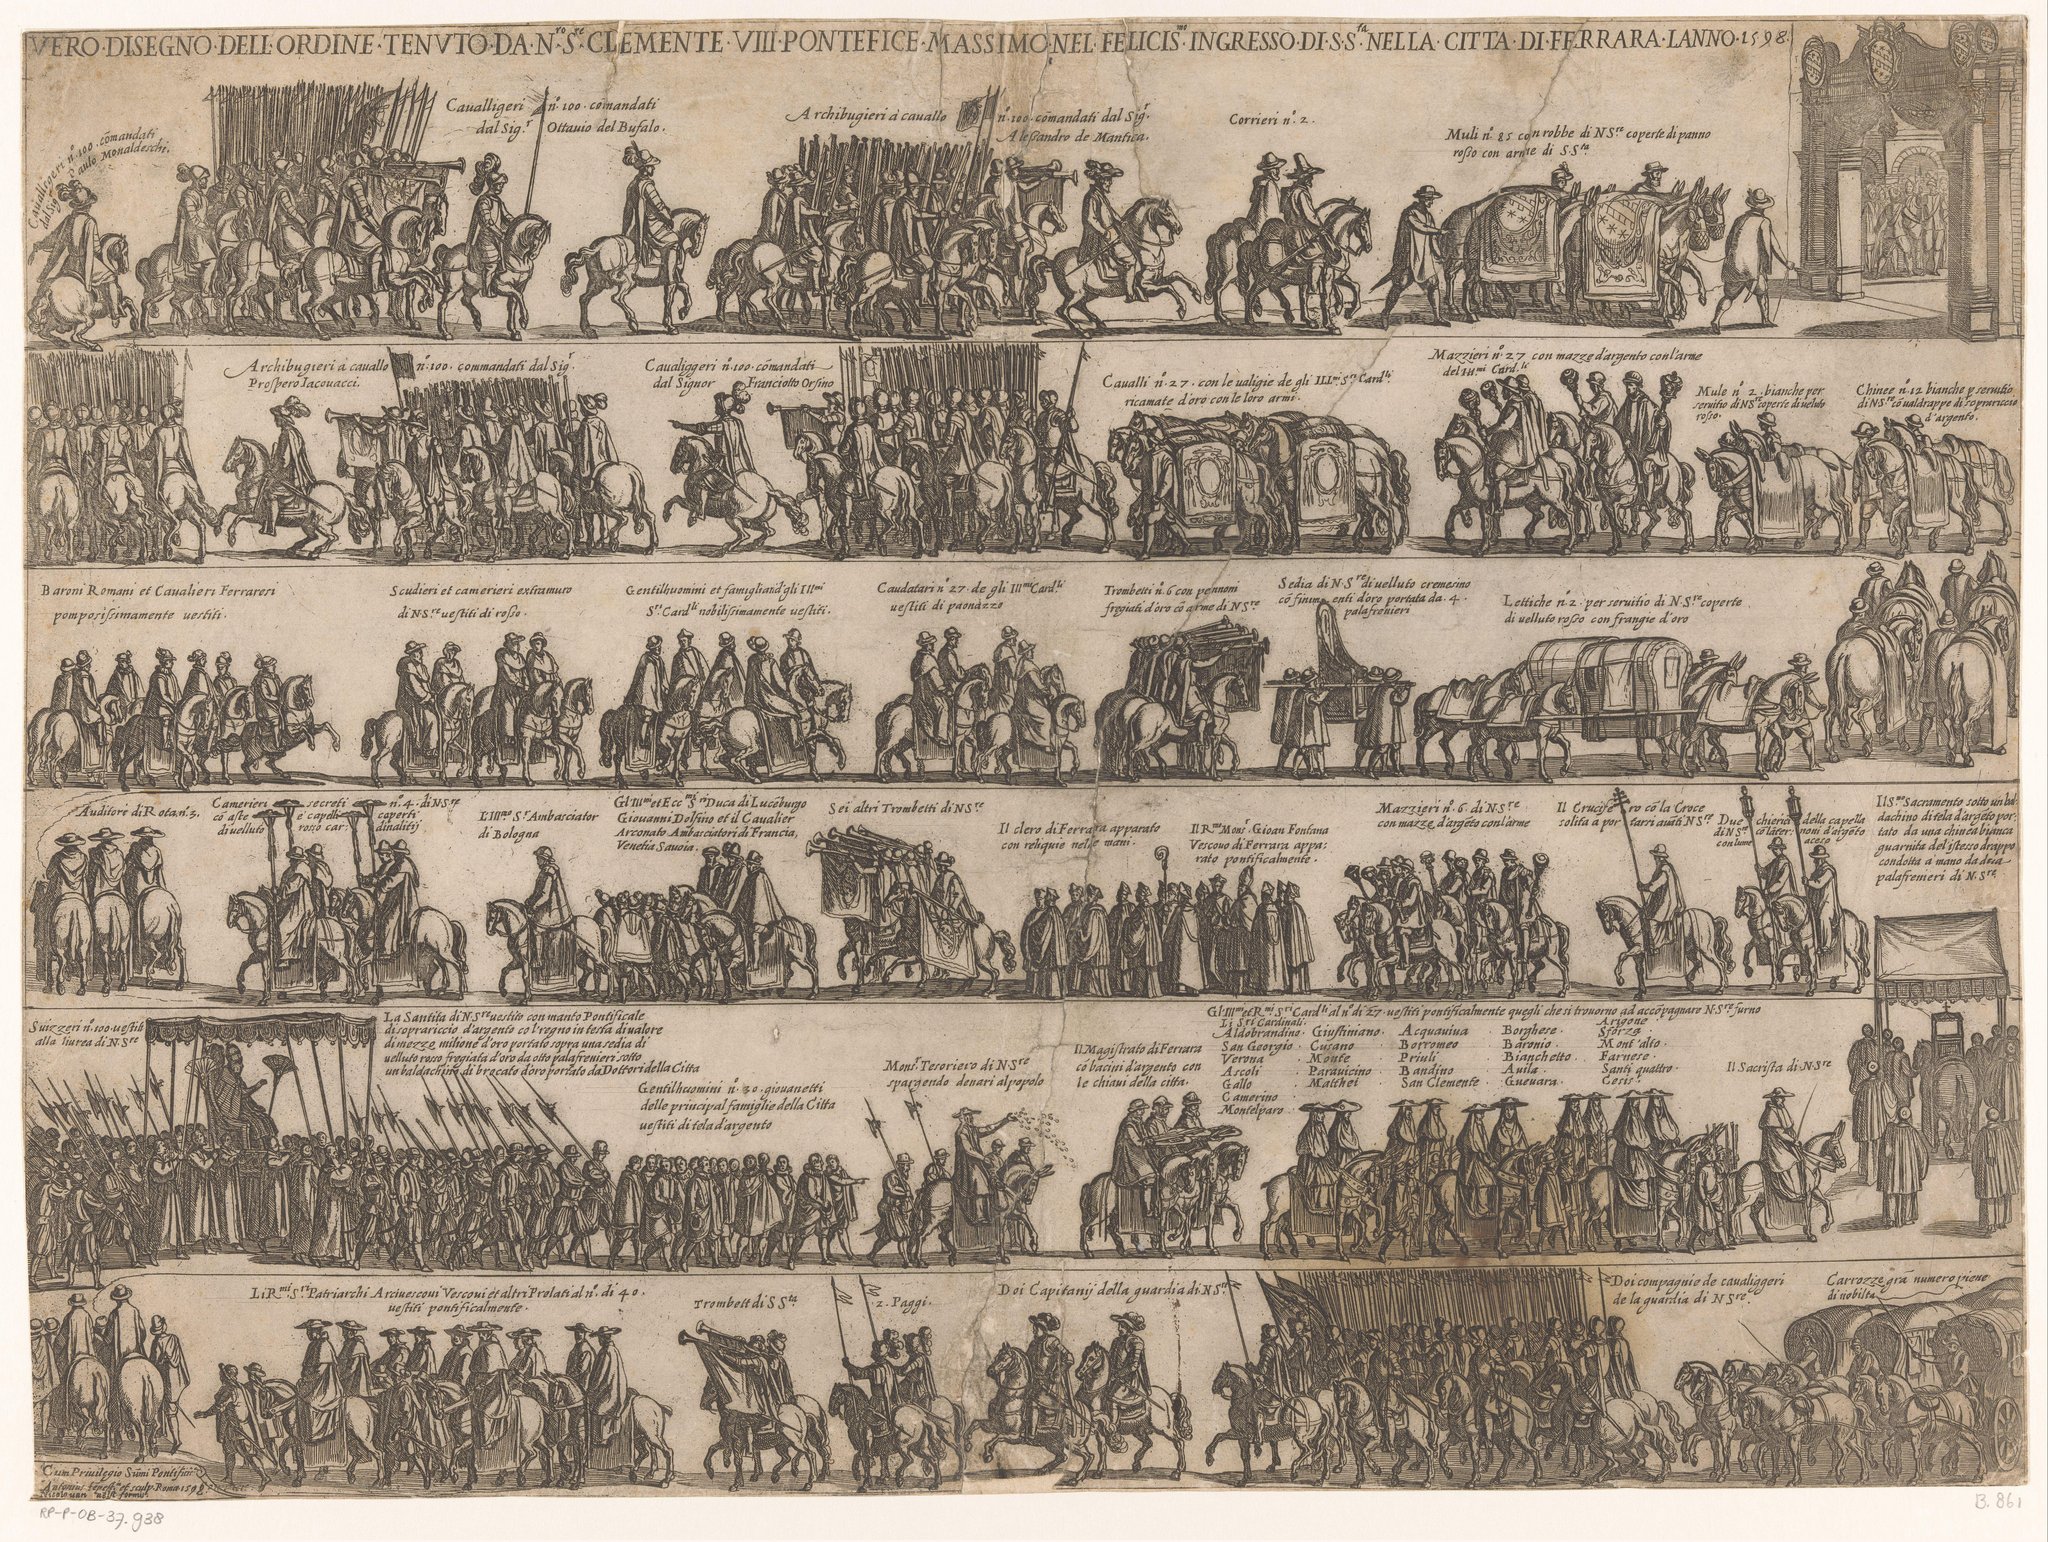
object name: print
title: Processie bij intocht van paus Clemens VIII in Ferrara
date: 1598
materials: paper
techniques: etching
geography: vatican city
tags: clemens viii, ceremonial procession, parade, pageant ~ pope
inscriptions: collector's mark: Lugt 240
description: Een processie met soldaten, kardinalen, paarden en paus Clemens VIII de stad Ferrara in. Boven elk groepje een bijschrift in het Italiaans.